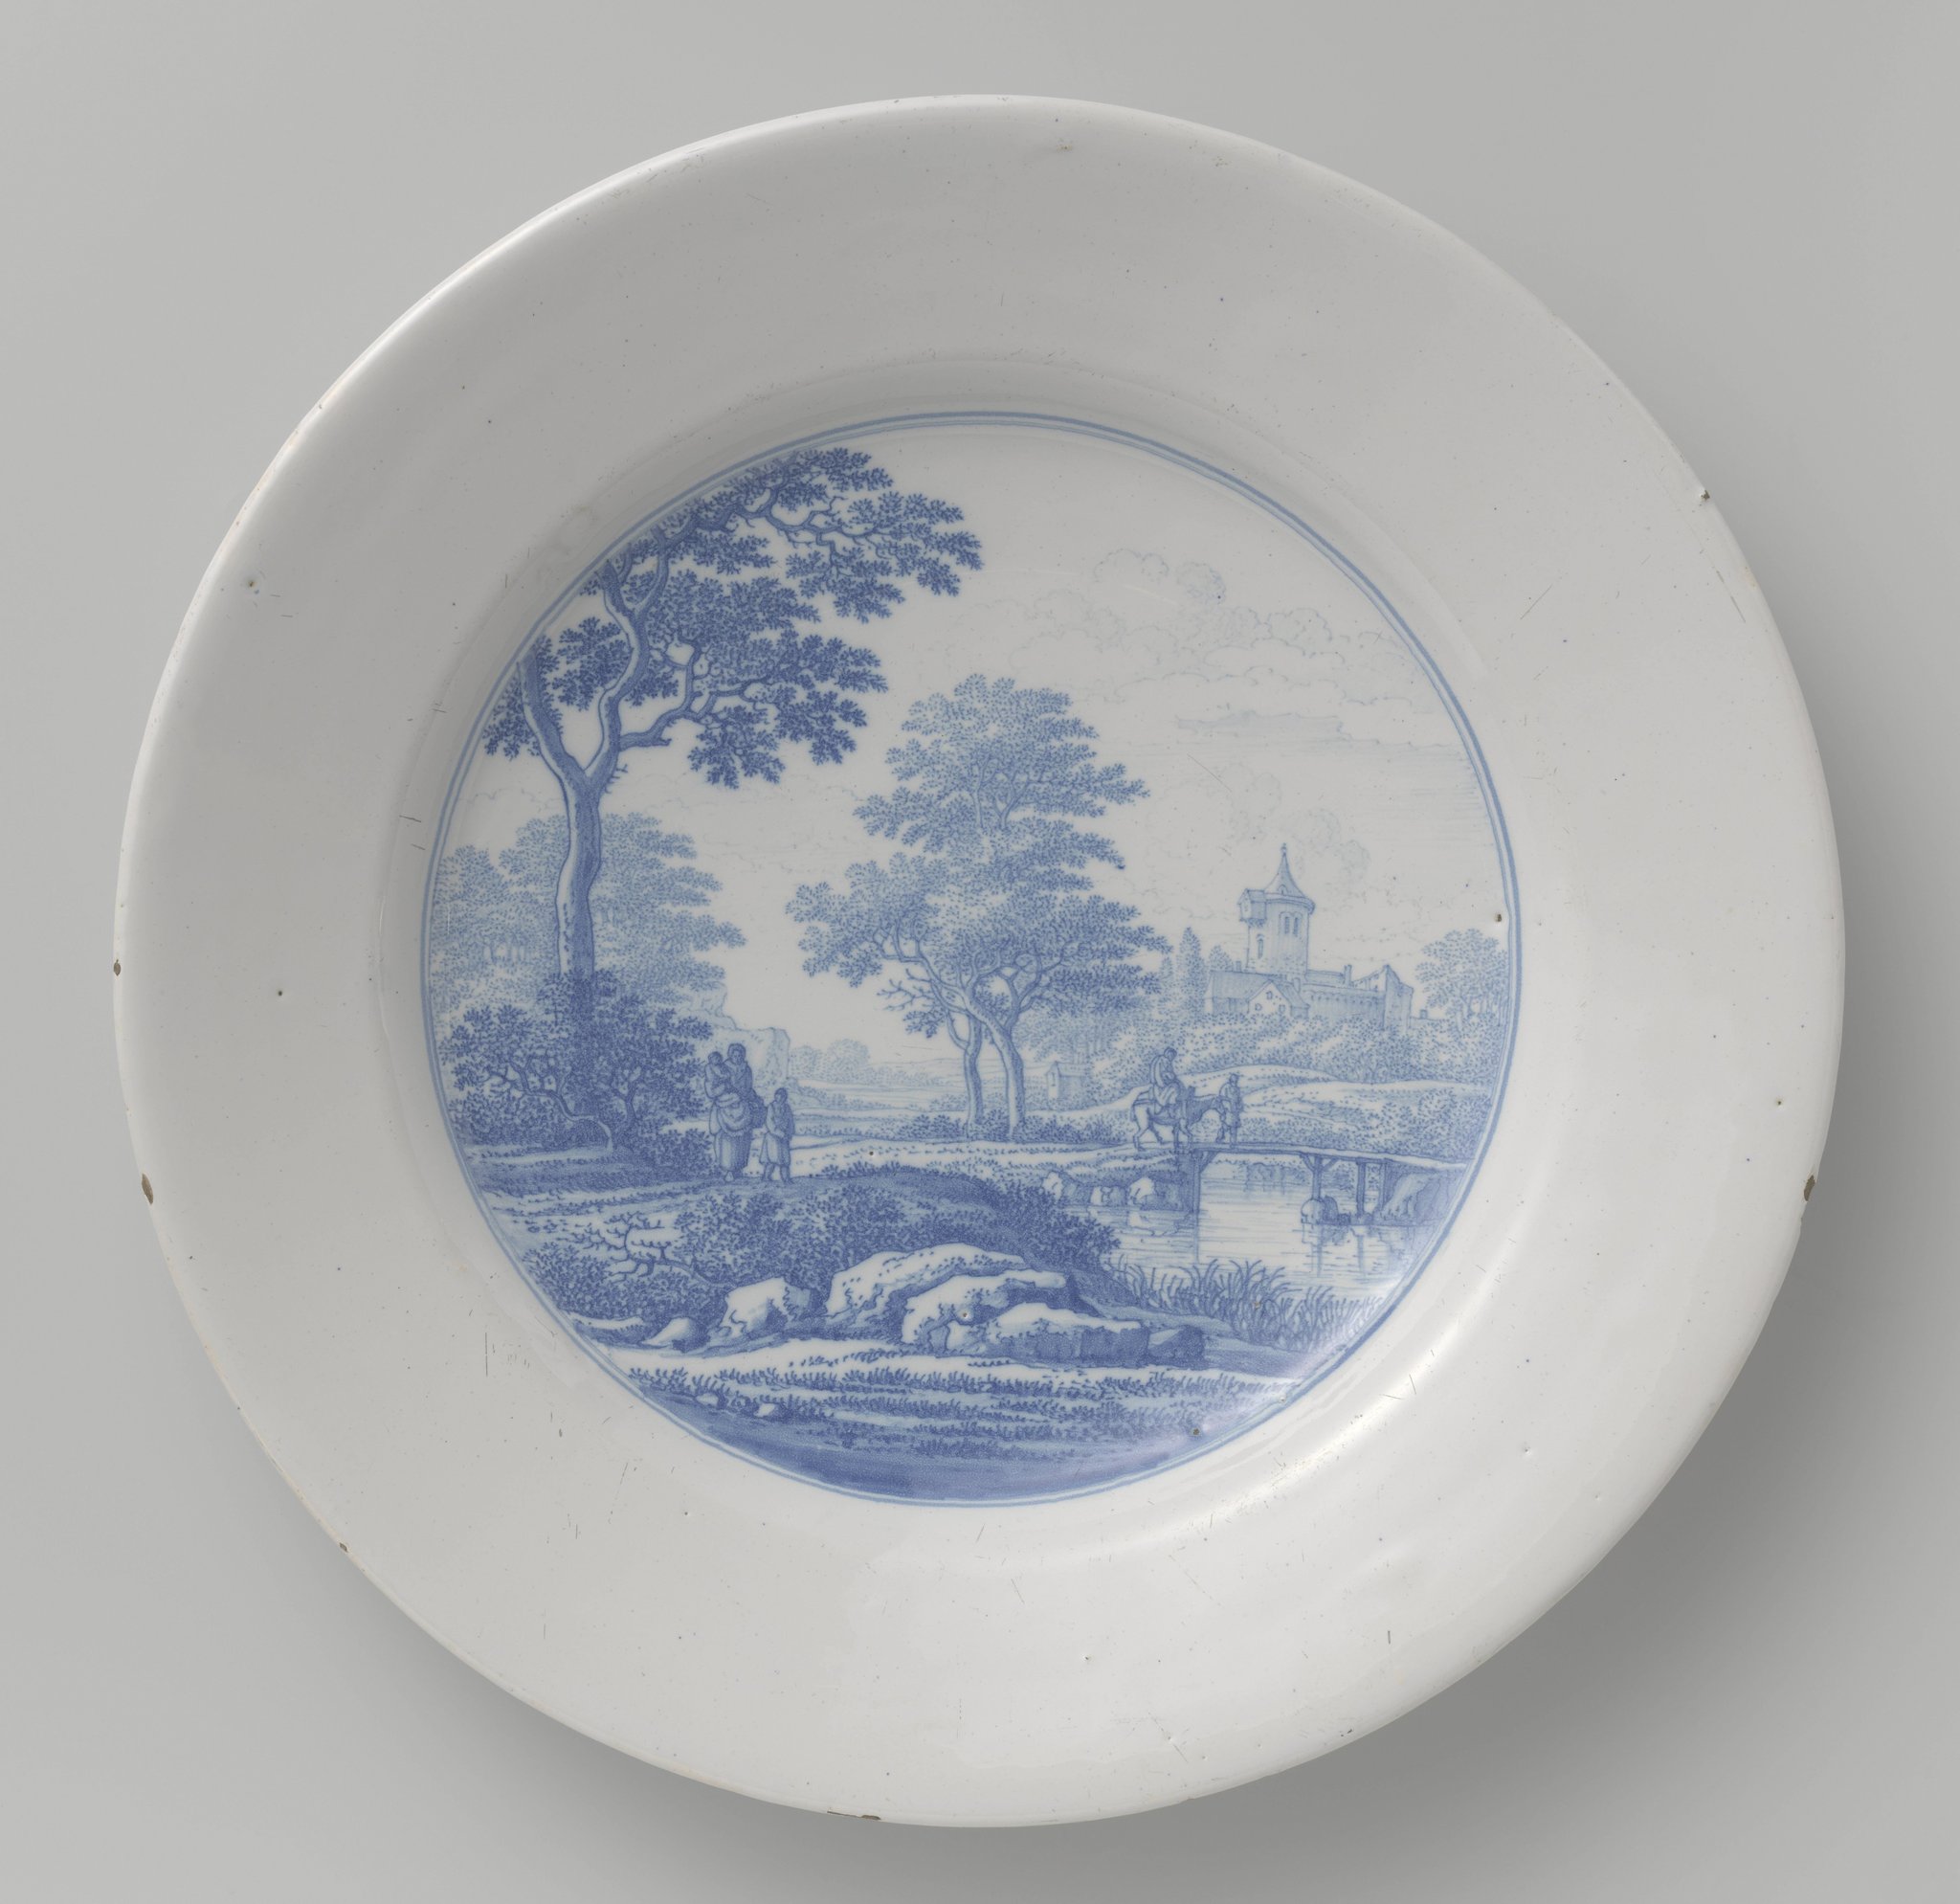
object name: platter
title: Dish with a Landscape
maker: frederik van frytom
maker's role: plateelschilder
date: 1670-1685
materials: earthenware, glaze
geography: delft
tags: landscapes in the temperate zone, road, path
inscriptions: collector's mark: ‘14’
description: The decoration of Delft tin-glazed earthenware was almost all done by anonymous craftsmen. An exception to this is Frederik van Frytom, who worked in Delft as an independent pottery painter. The superior quality of his painted decorations betrays his training as a fine art painter.